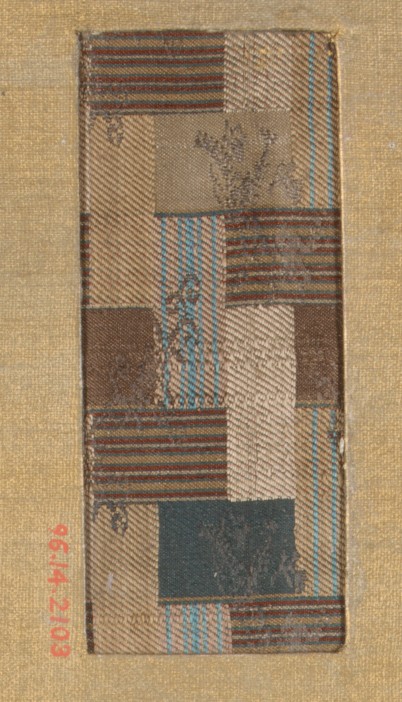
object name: piece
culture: japanese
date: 1701-1900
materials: silk